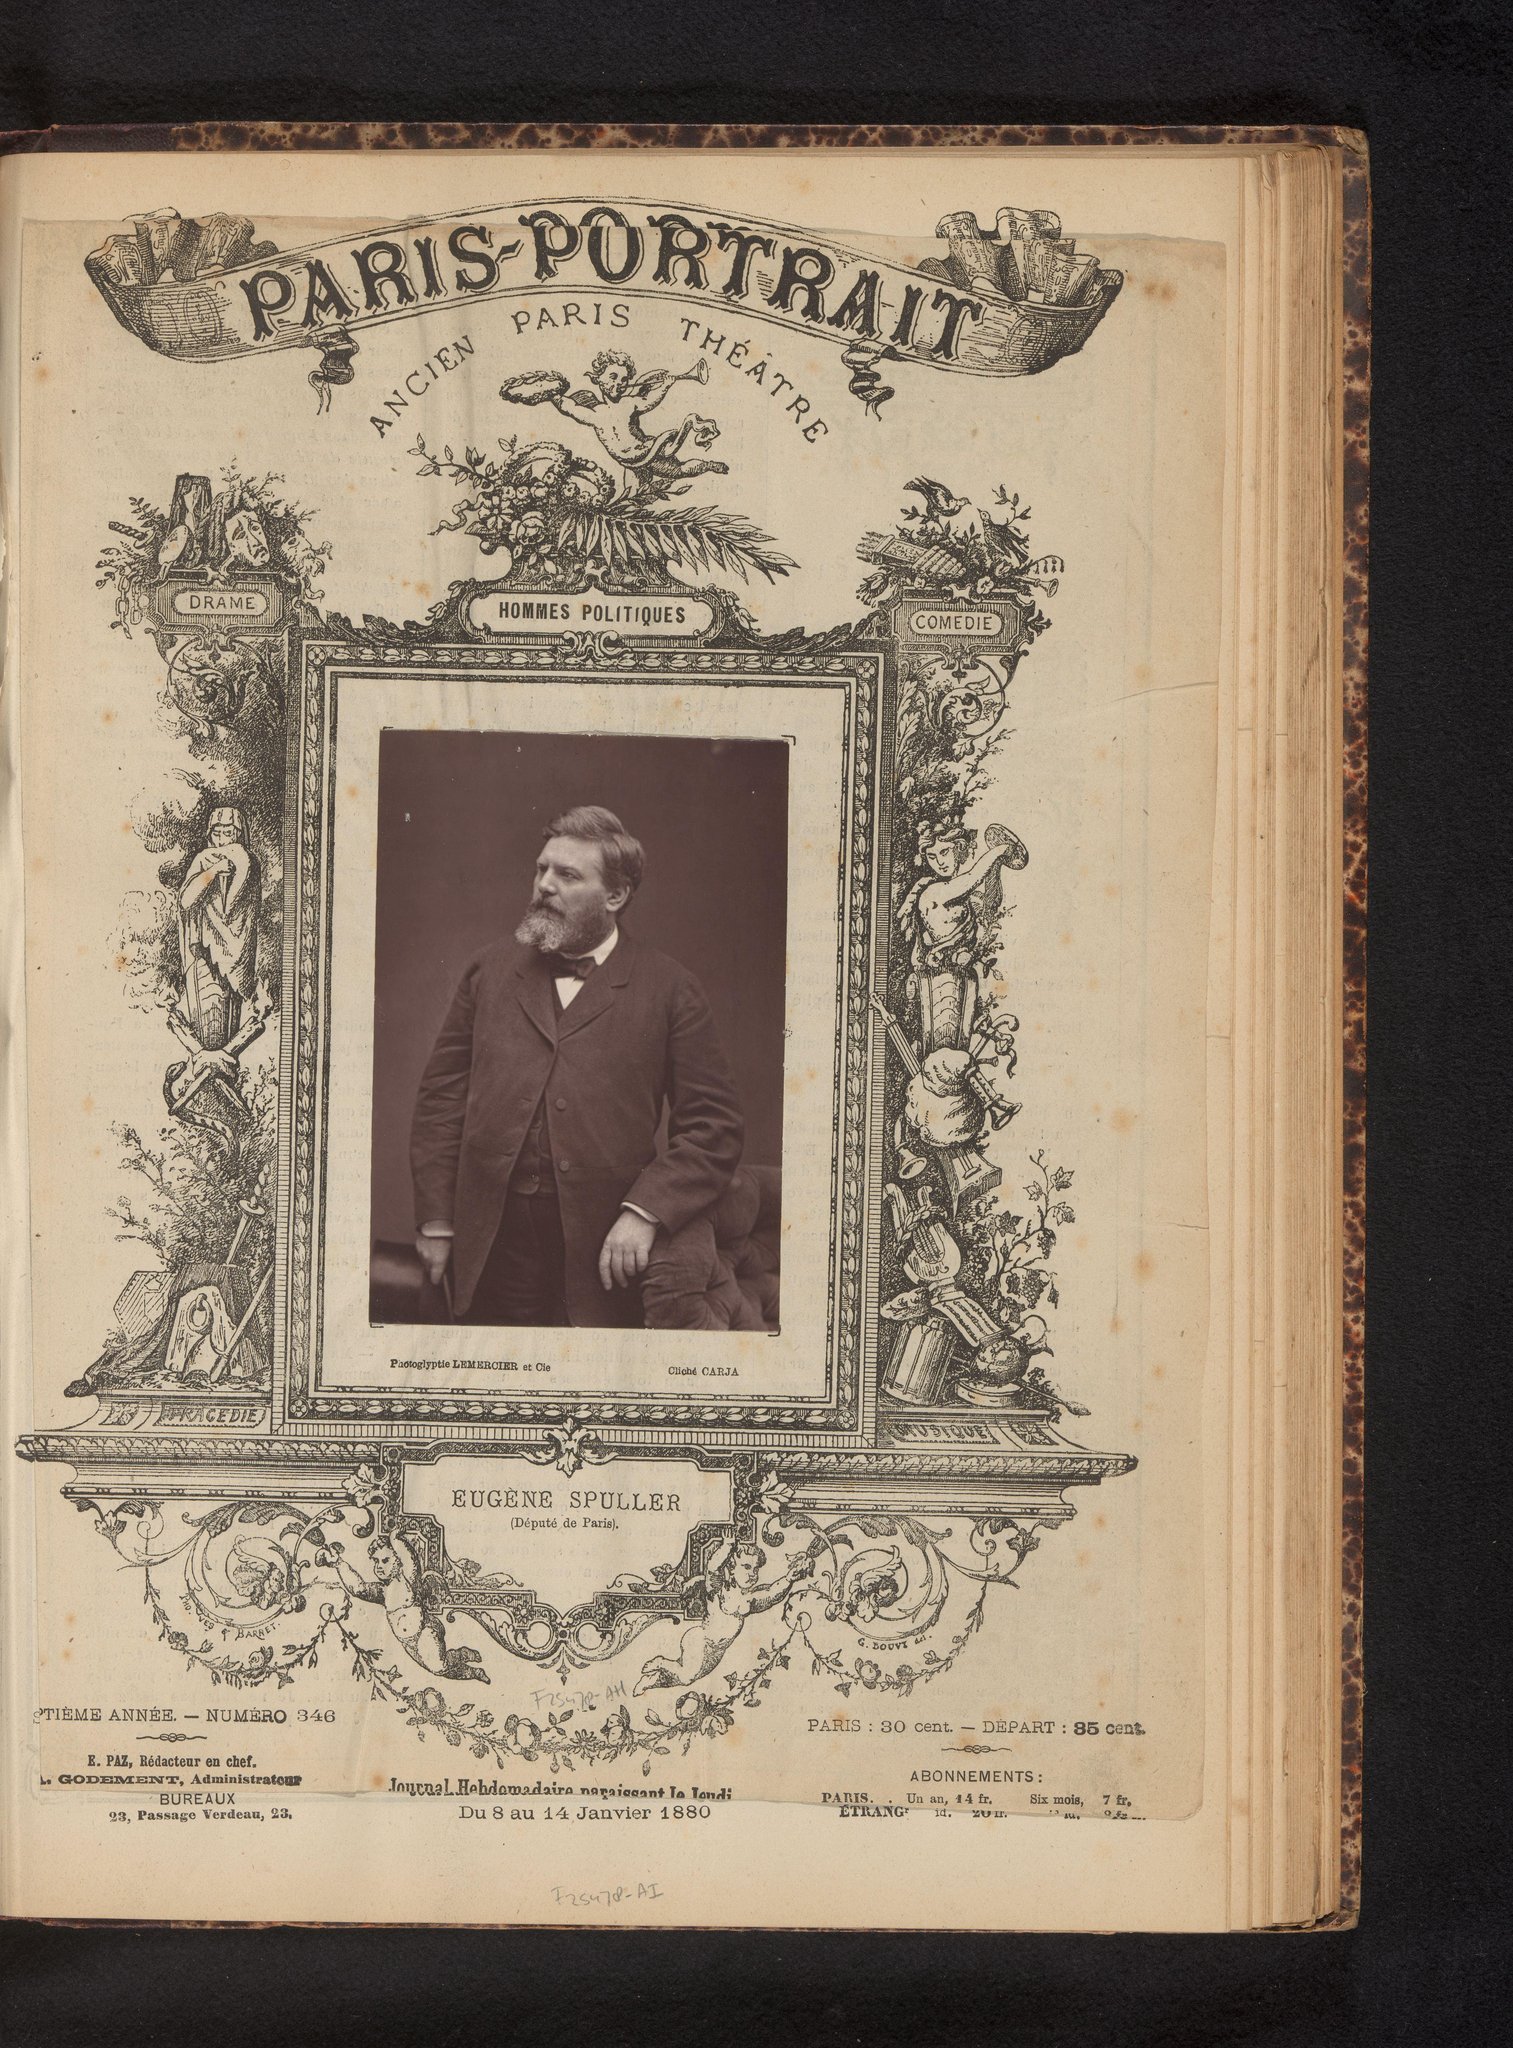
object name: photomechanical print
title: Eugene Spuller (Député de Paris)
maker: étienne carjat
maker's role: draughtsman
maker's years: 1828-1906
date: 1873-1880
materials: paper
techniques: woodburytype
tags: politician, historical persons